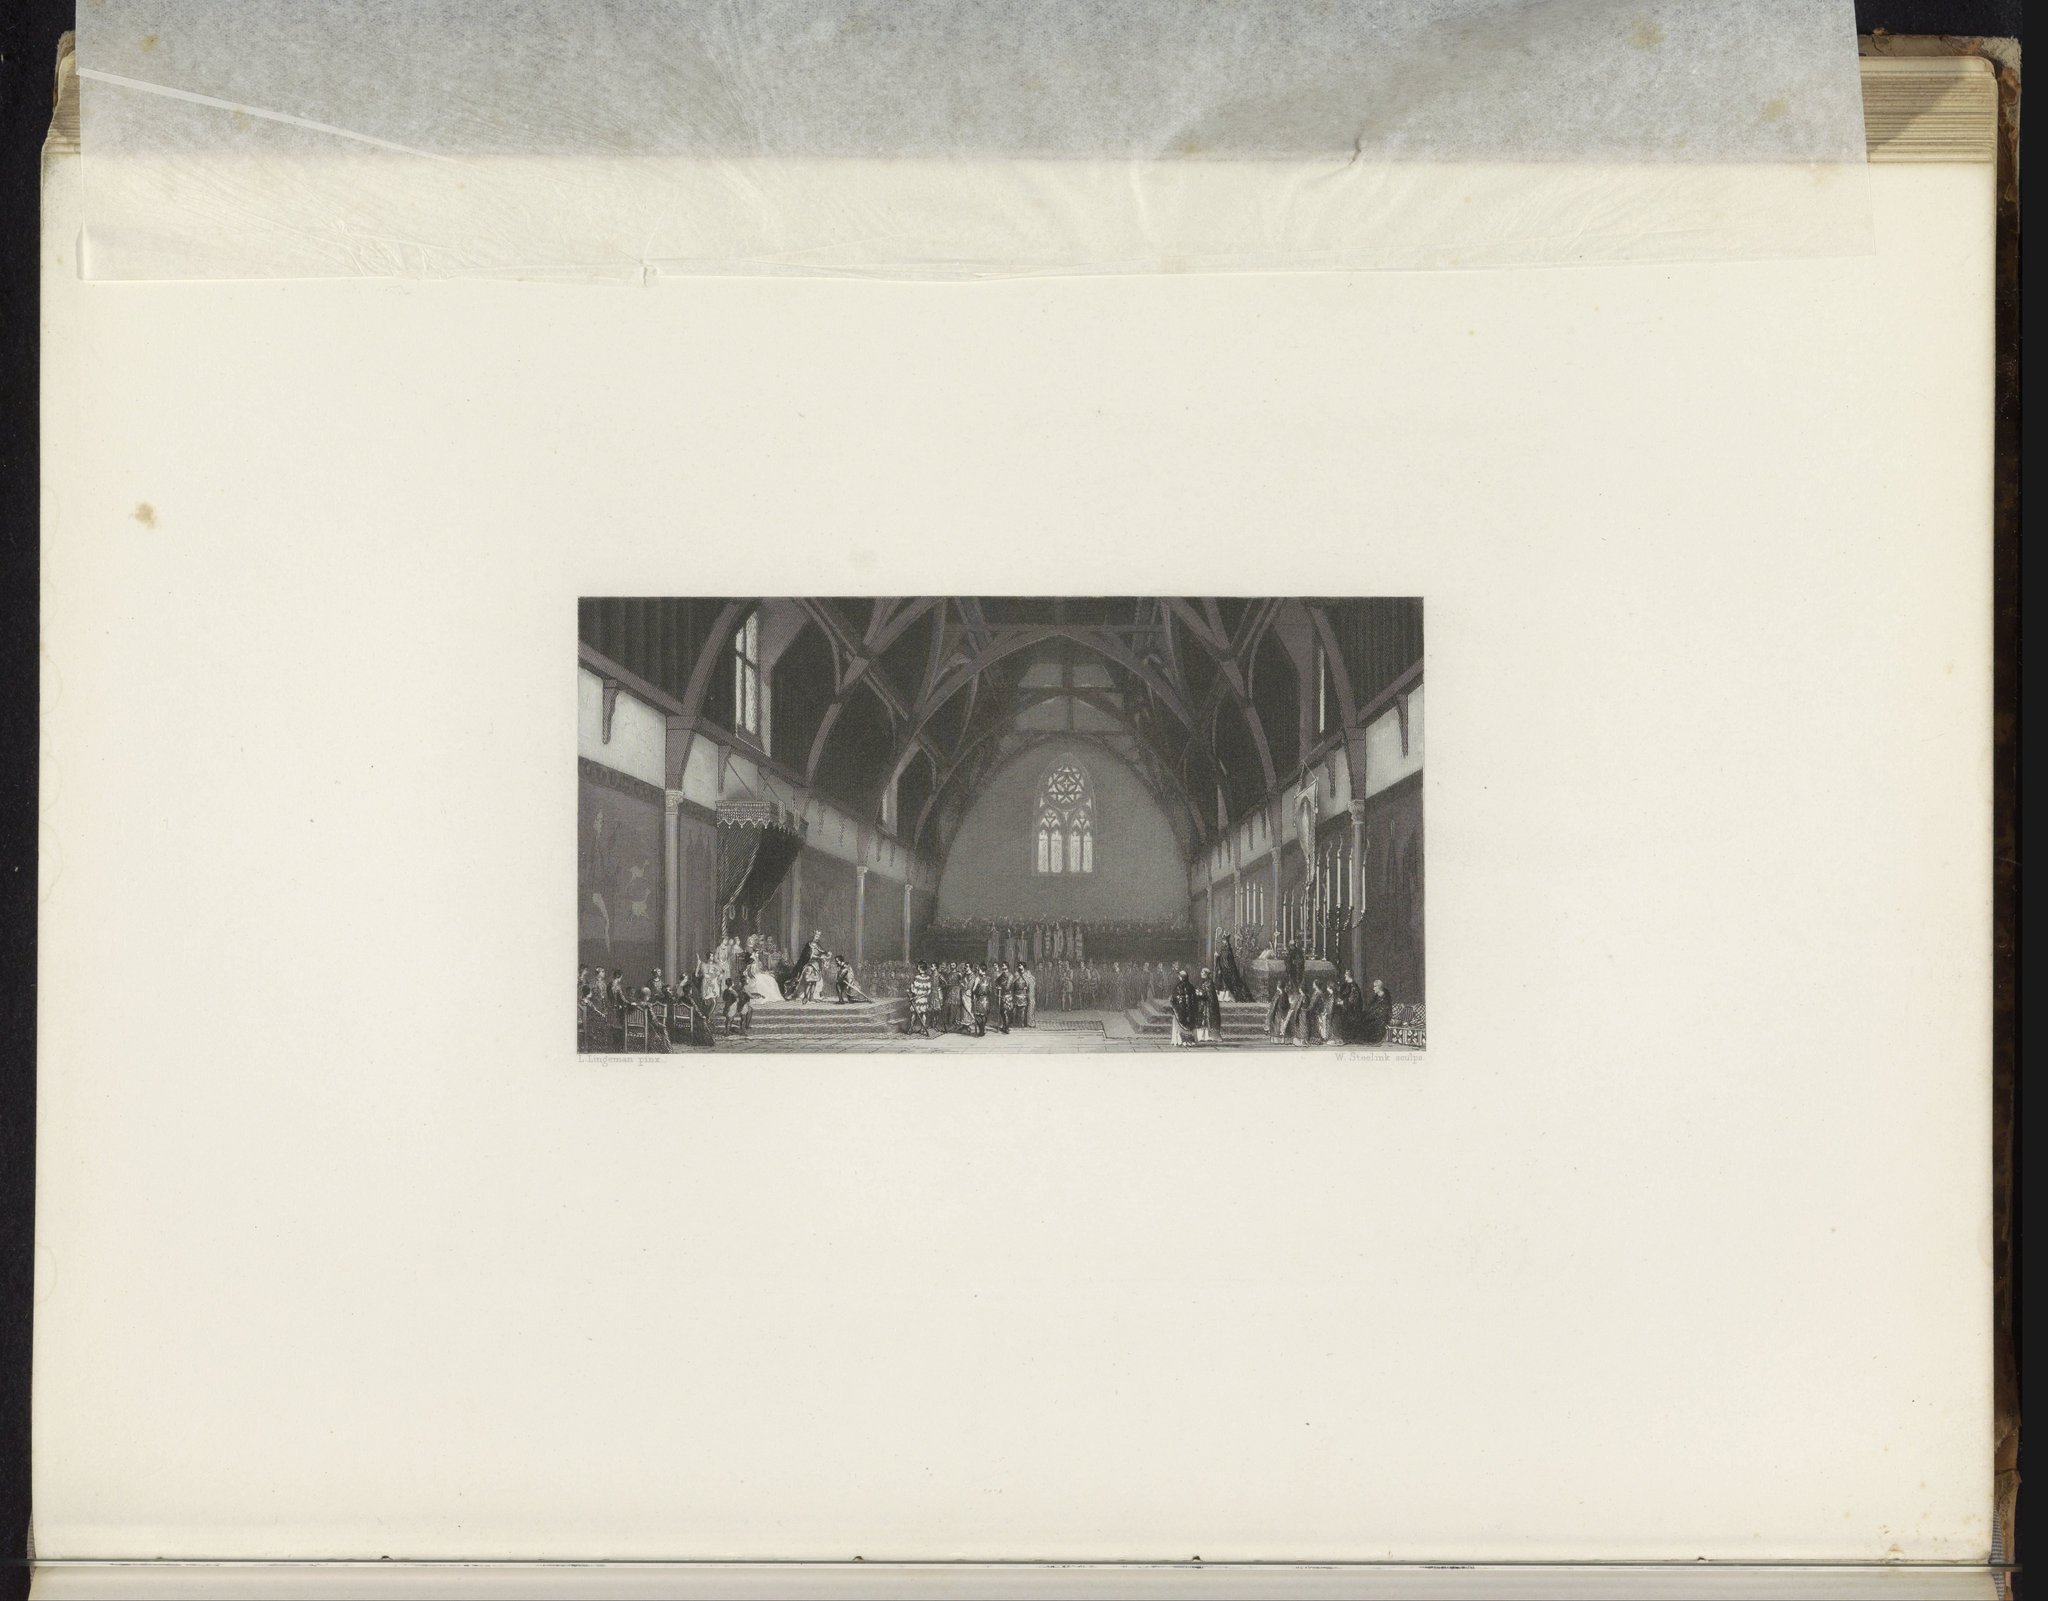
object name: print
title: Graaf Floris V sticht de orde van St. Jacob, 1290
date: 1865-1870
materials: paper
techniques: engraving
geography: netherlands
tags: leiden, floris v (graaf van holland en zeeland), knighthood order, netherlands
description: Graaf Floris V sticht de orde van St. Jacob in 1290. Ceremonie in interieur van een kerk of paleis. Onderdeel van de groep staalgravures naar de schilderijen van de Historische Galerij der Maatschappij Arti et Amicitiae.